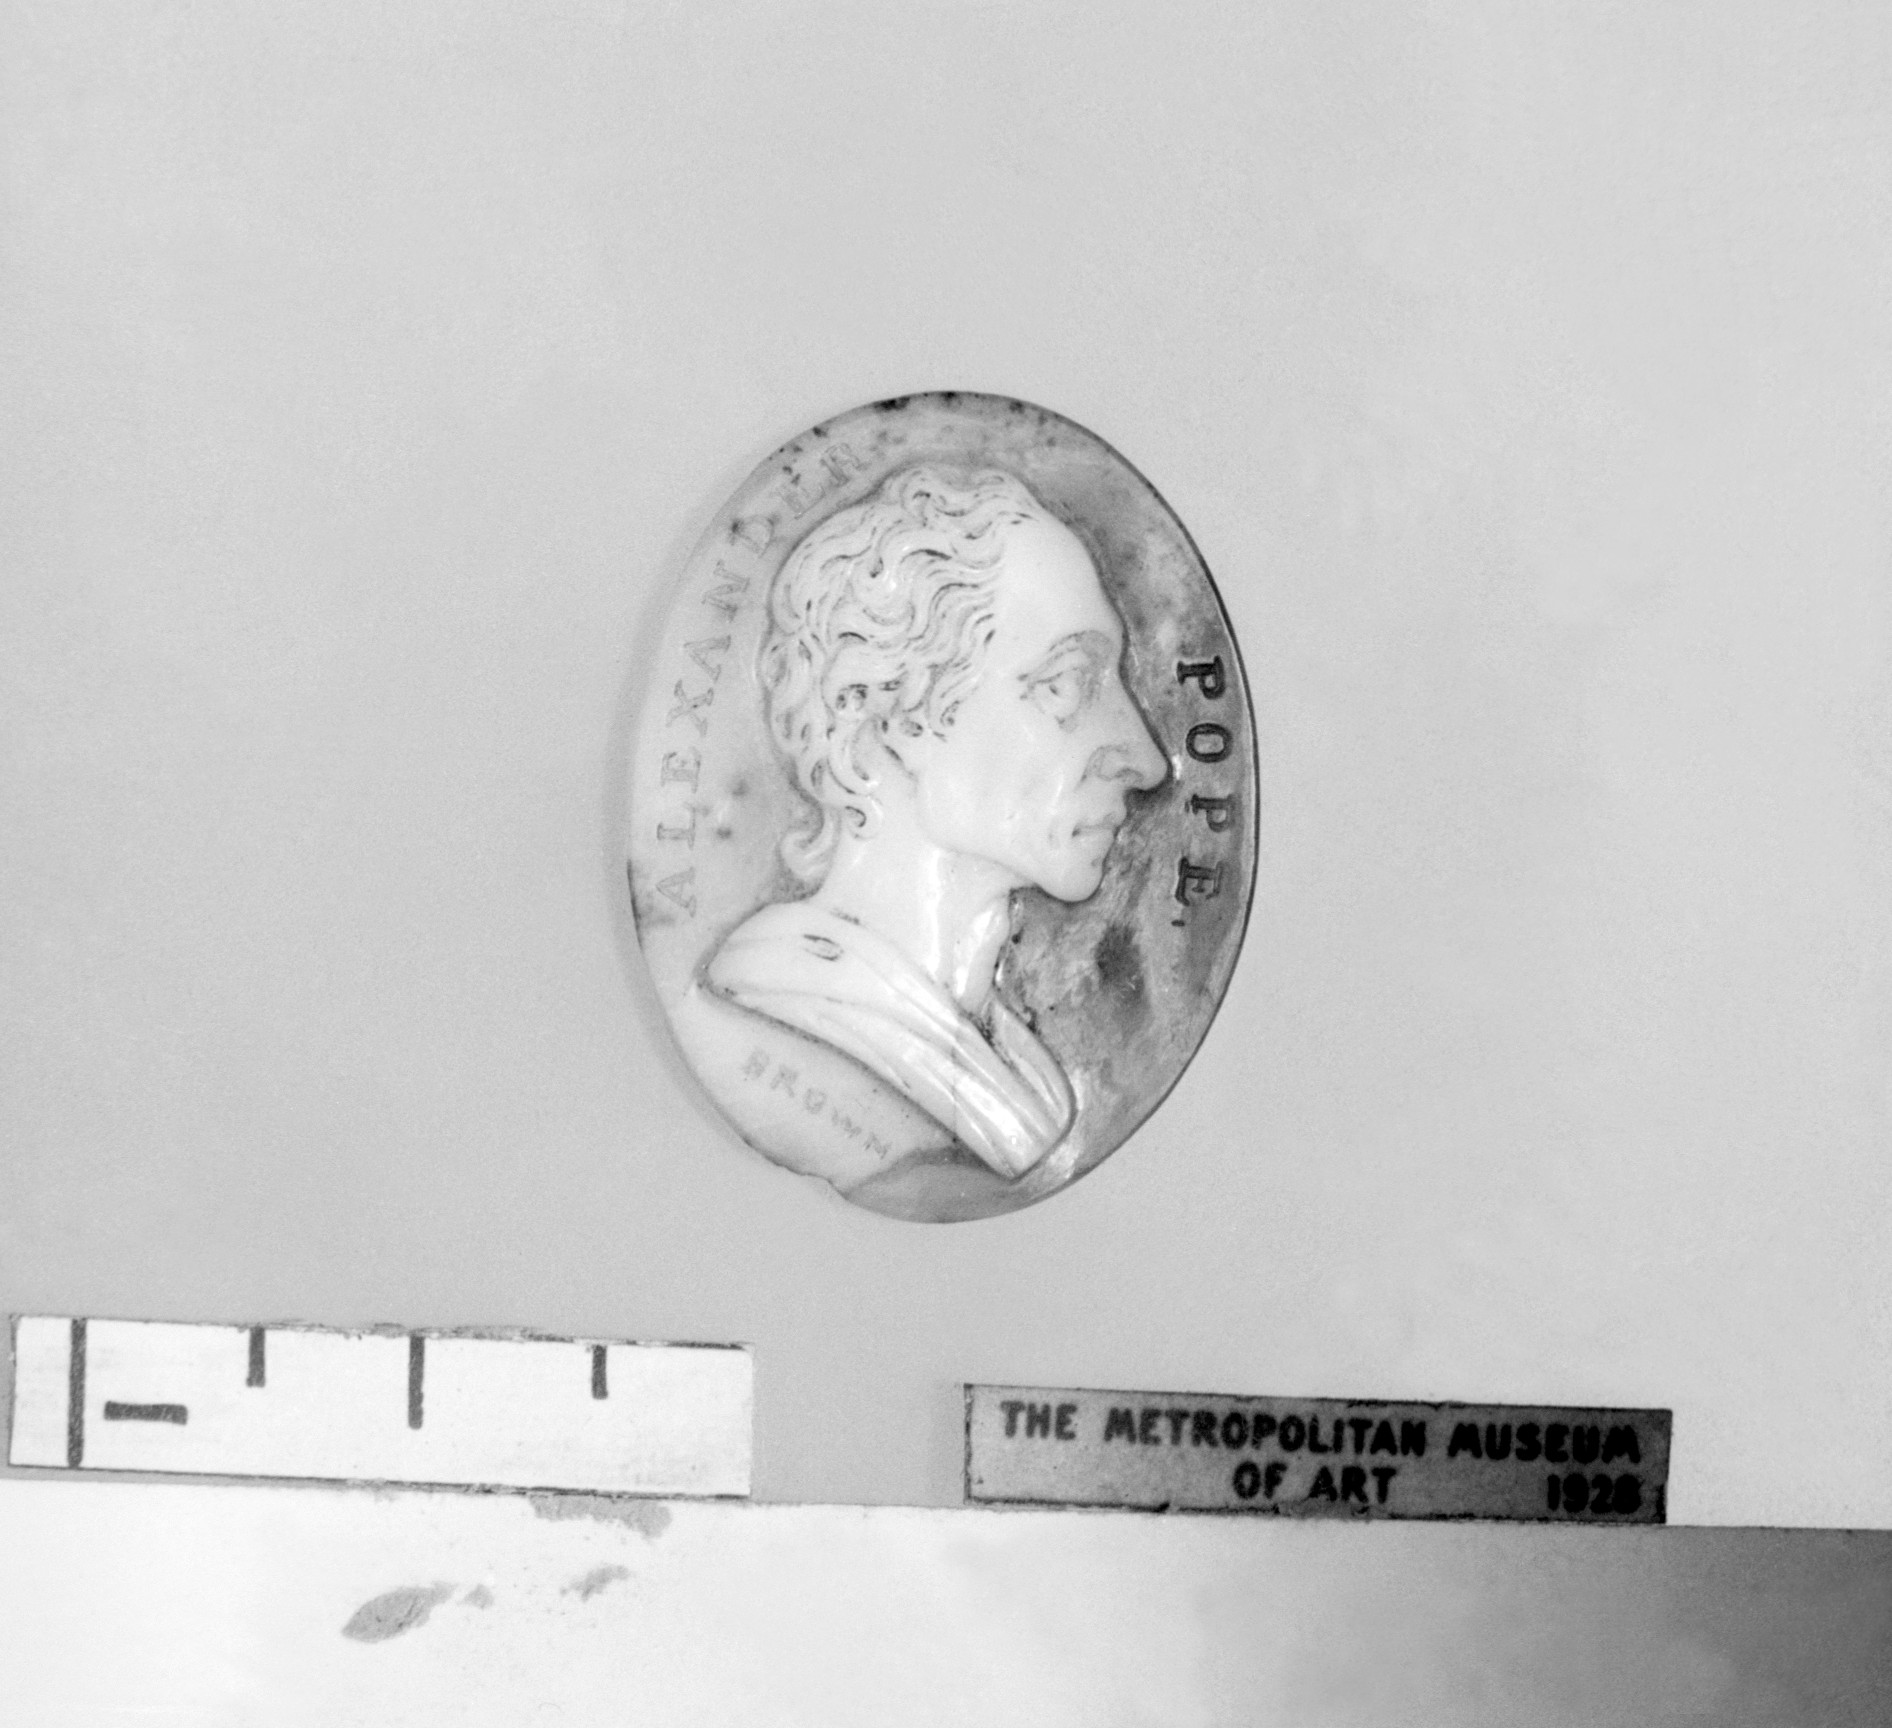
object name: cameo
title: Alexander Pope (1688–1744)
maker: william brown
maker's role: artist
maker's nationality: british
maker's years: 1748-1825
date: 1801-1833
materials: gemstone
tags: men,profiles,popes